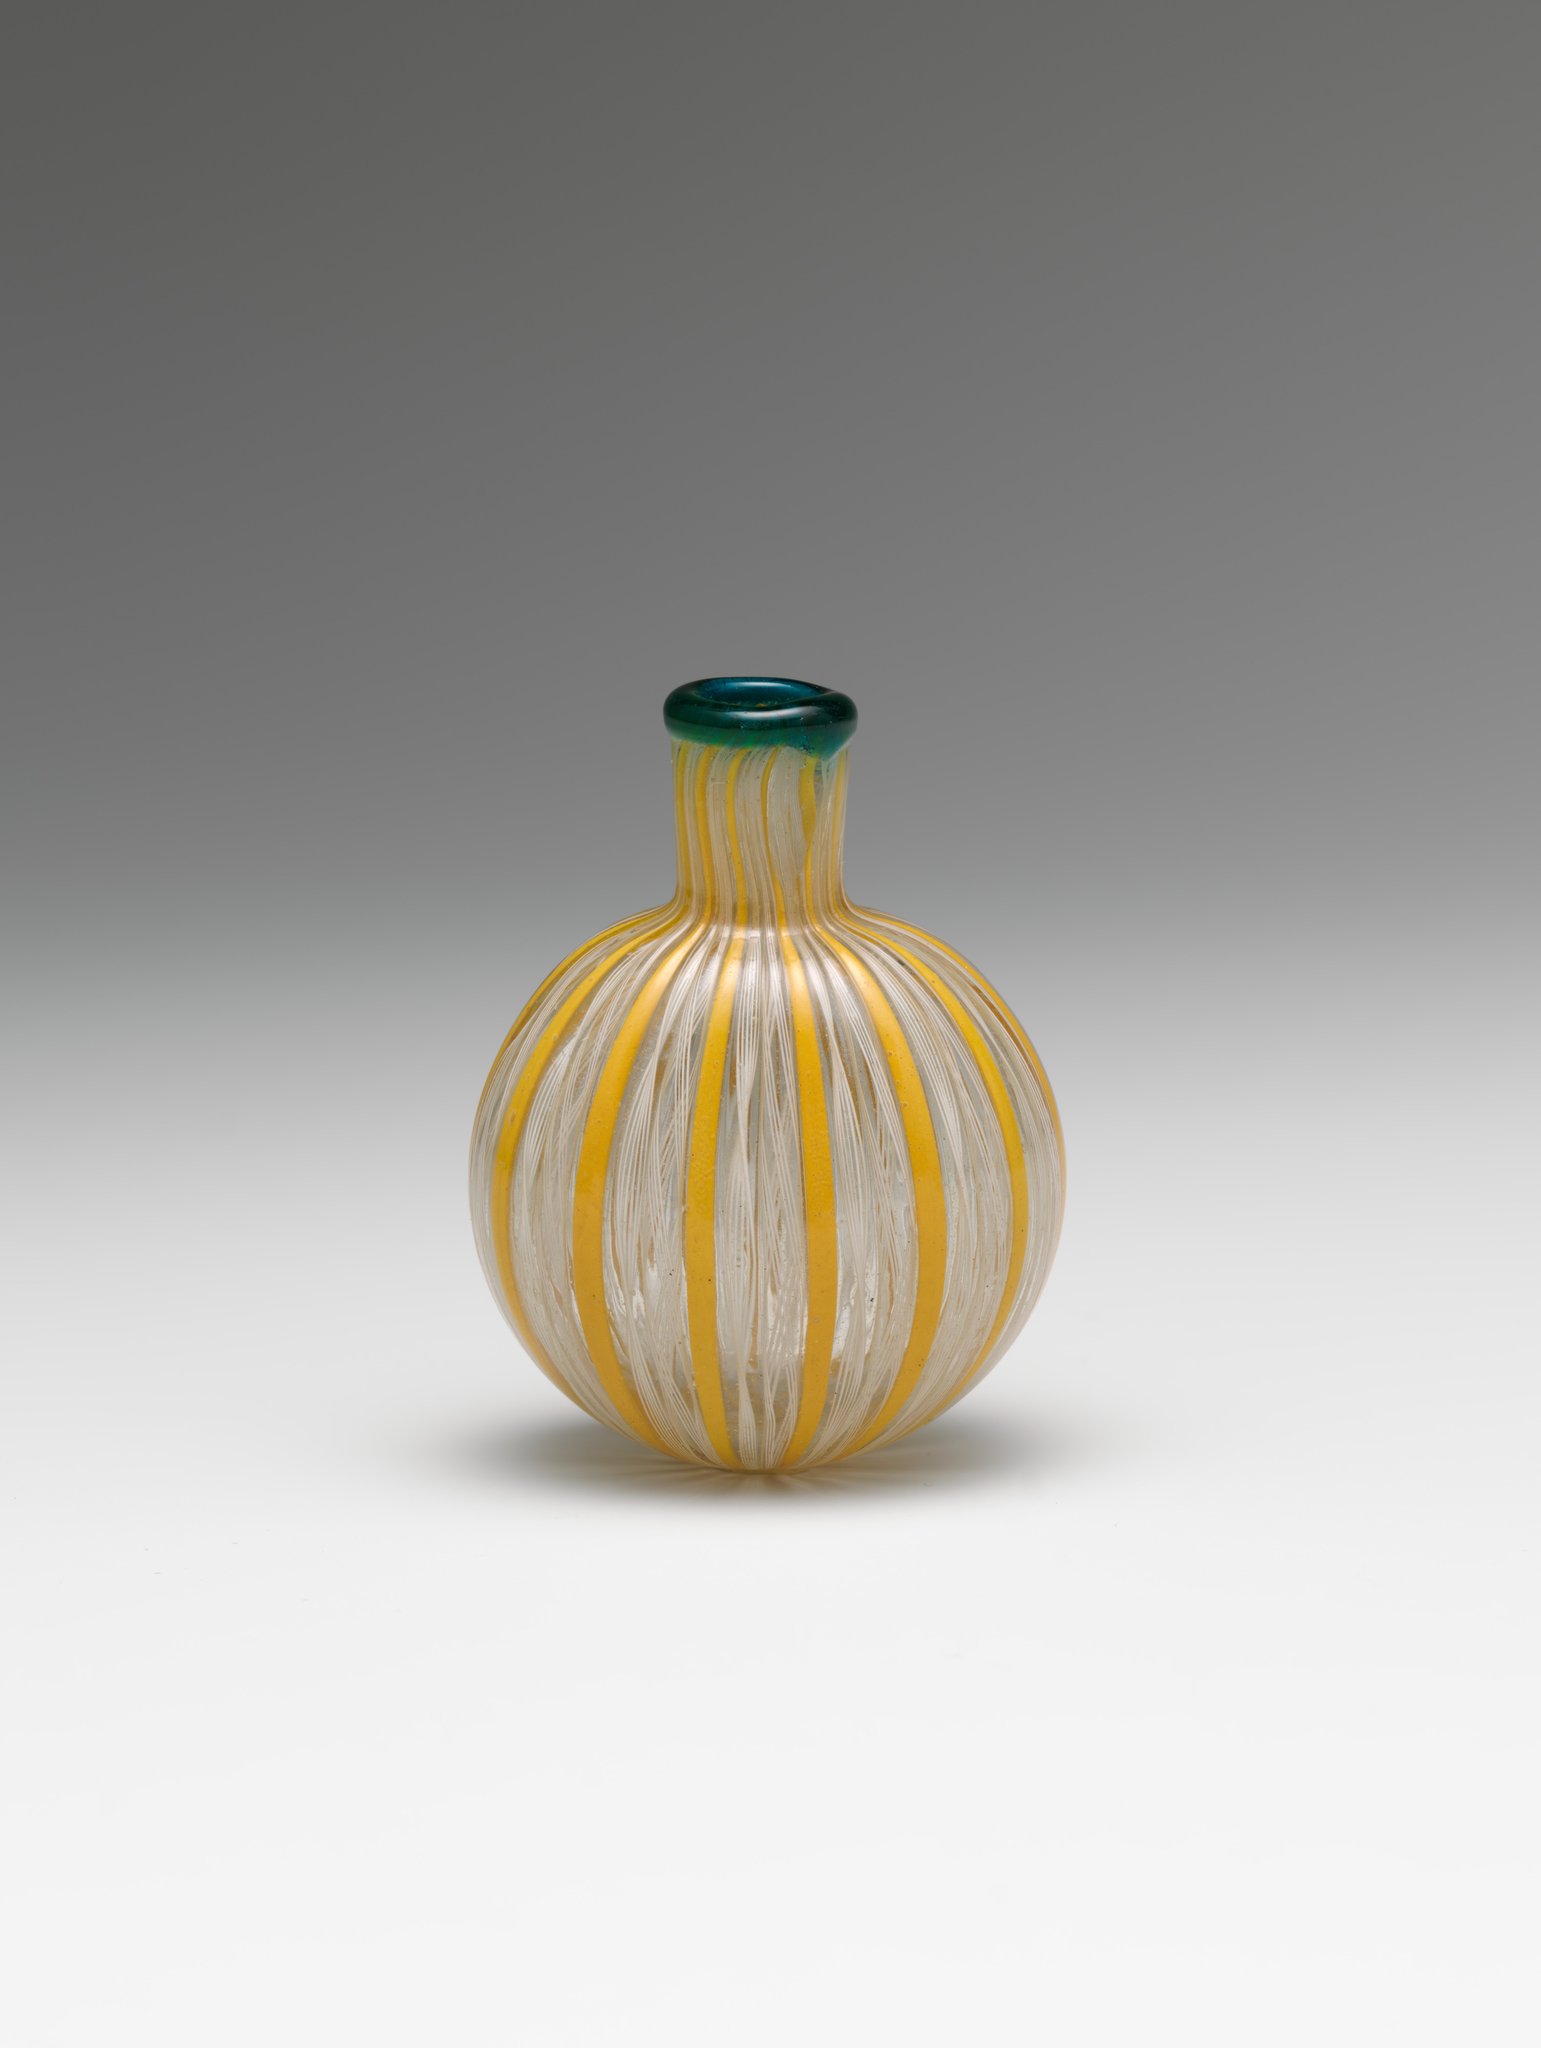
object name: flask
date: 1601-1800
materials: glass